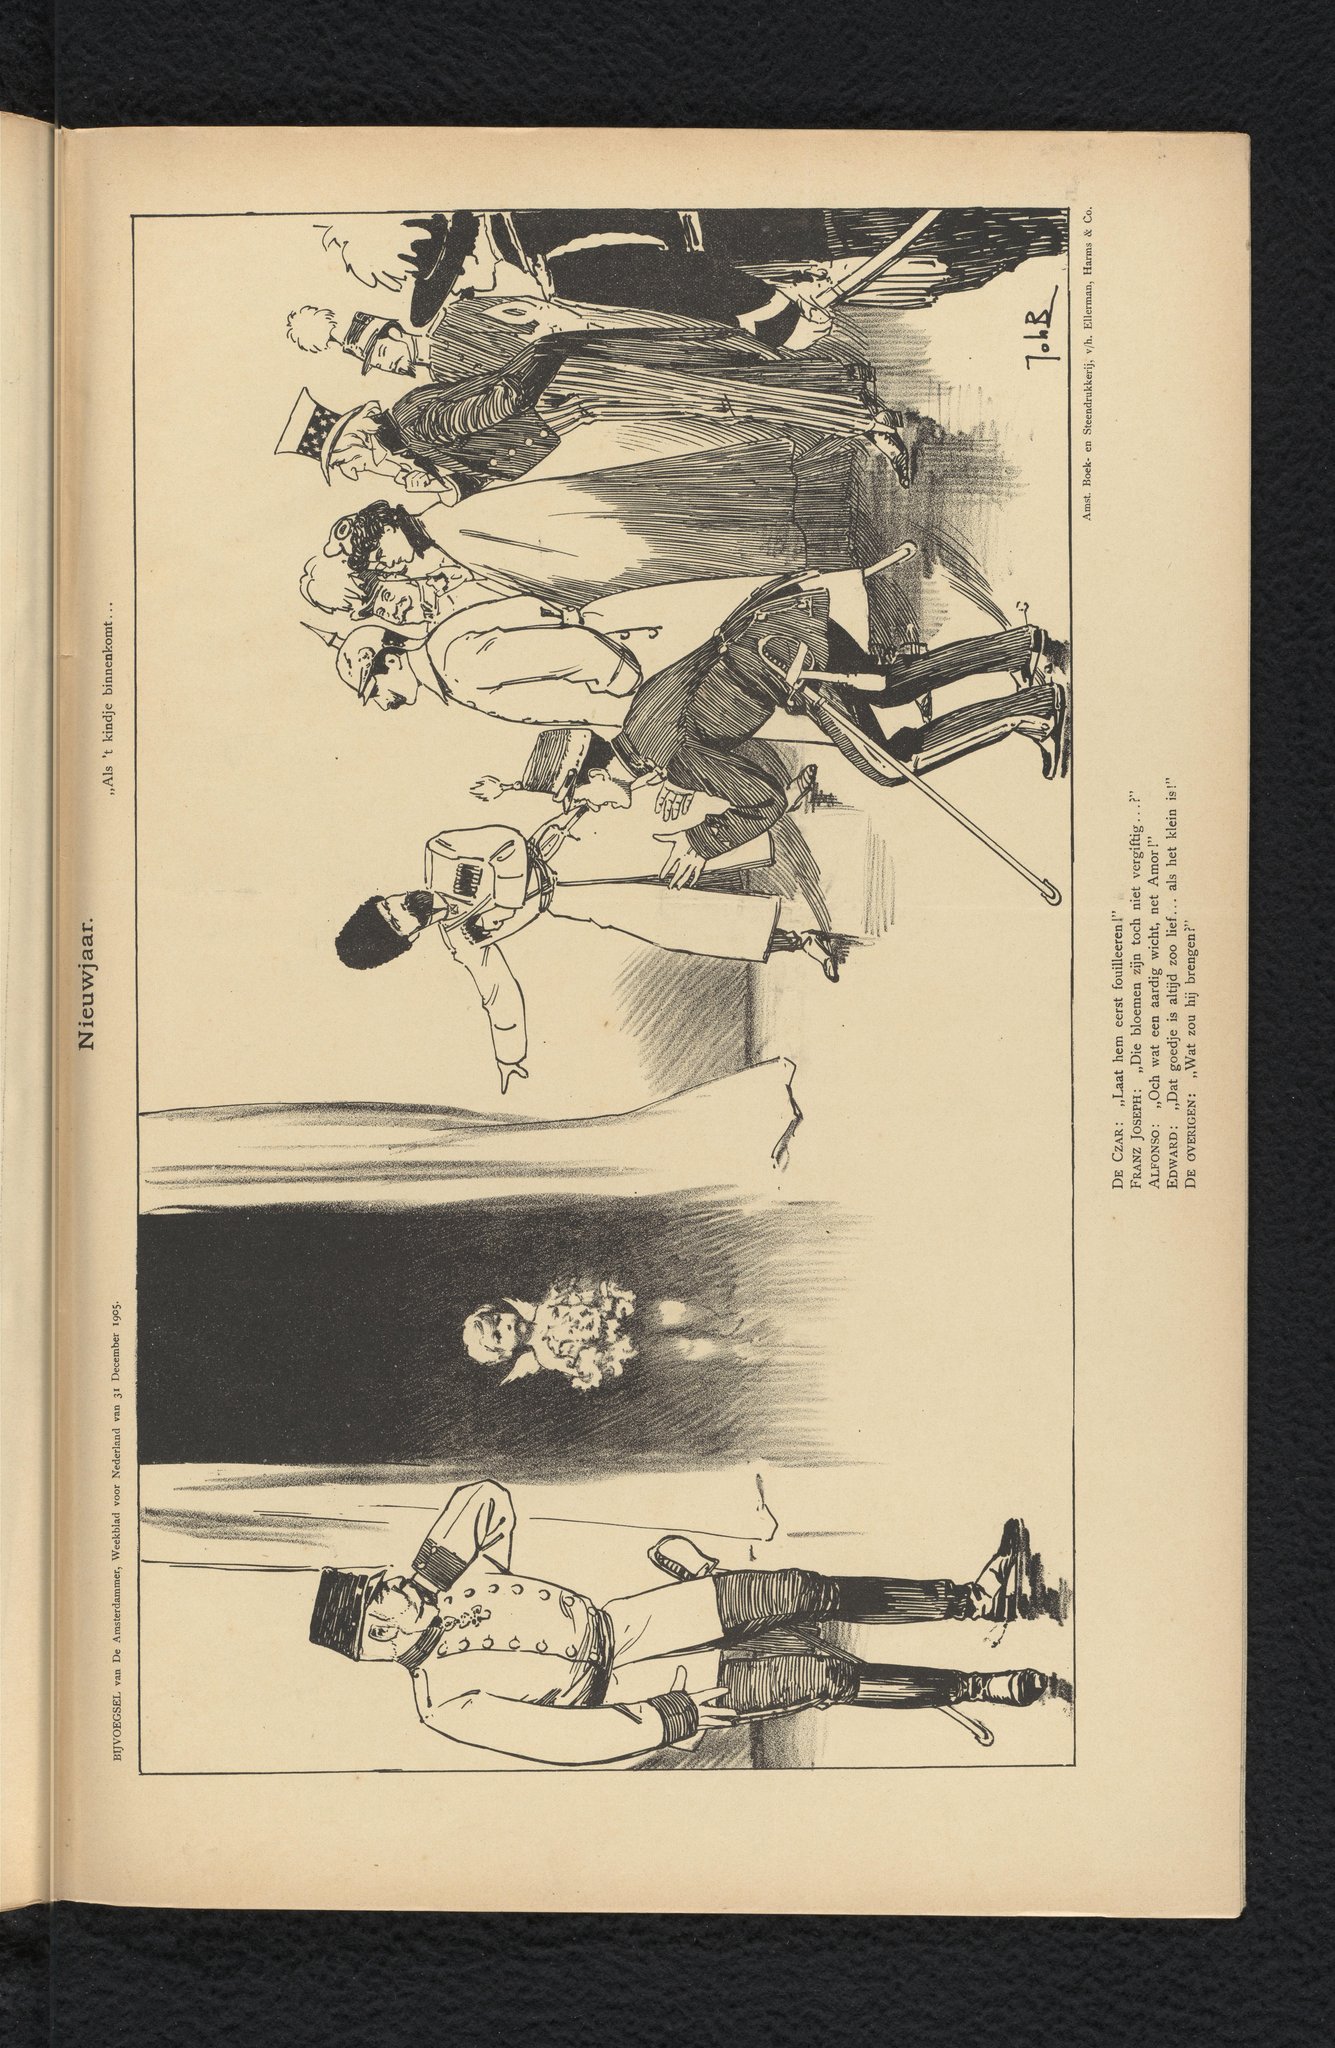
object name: cartoon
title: Nieuwjaar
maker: johan braakensiek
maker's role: draughtsman, print maker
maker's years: 1858-1940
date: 1905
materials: paper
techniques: lithograph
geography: amsterdam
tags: personifications of countries, nations, states, districts, etc., new year's eve (december 31), january 1 (~ festivities), political caricatures and satires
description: De leiders van de grote mogendheden wantrouwend bij de verschijning van het een klein jongetje met een bos bloemen, het nieuwe jaar.